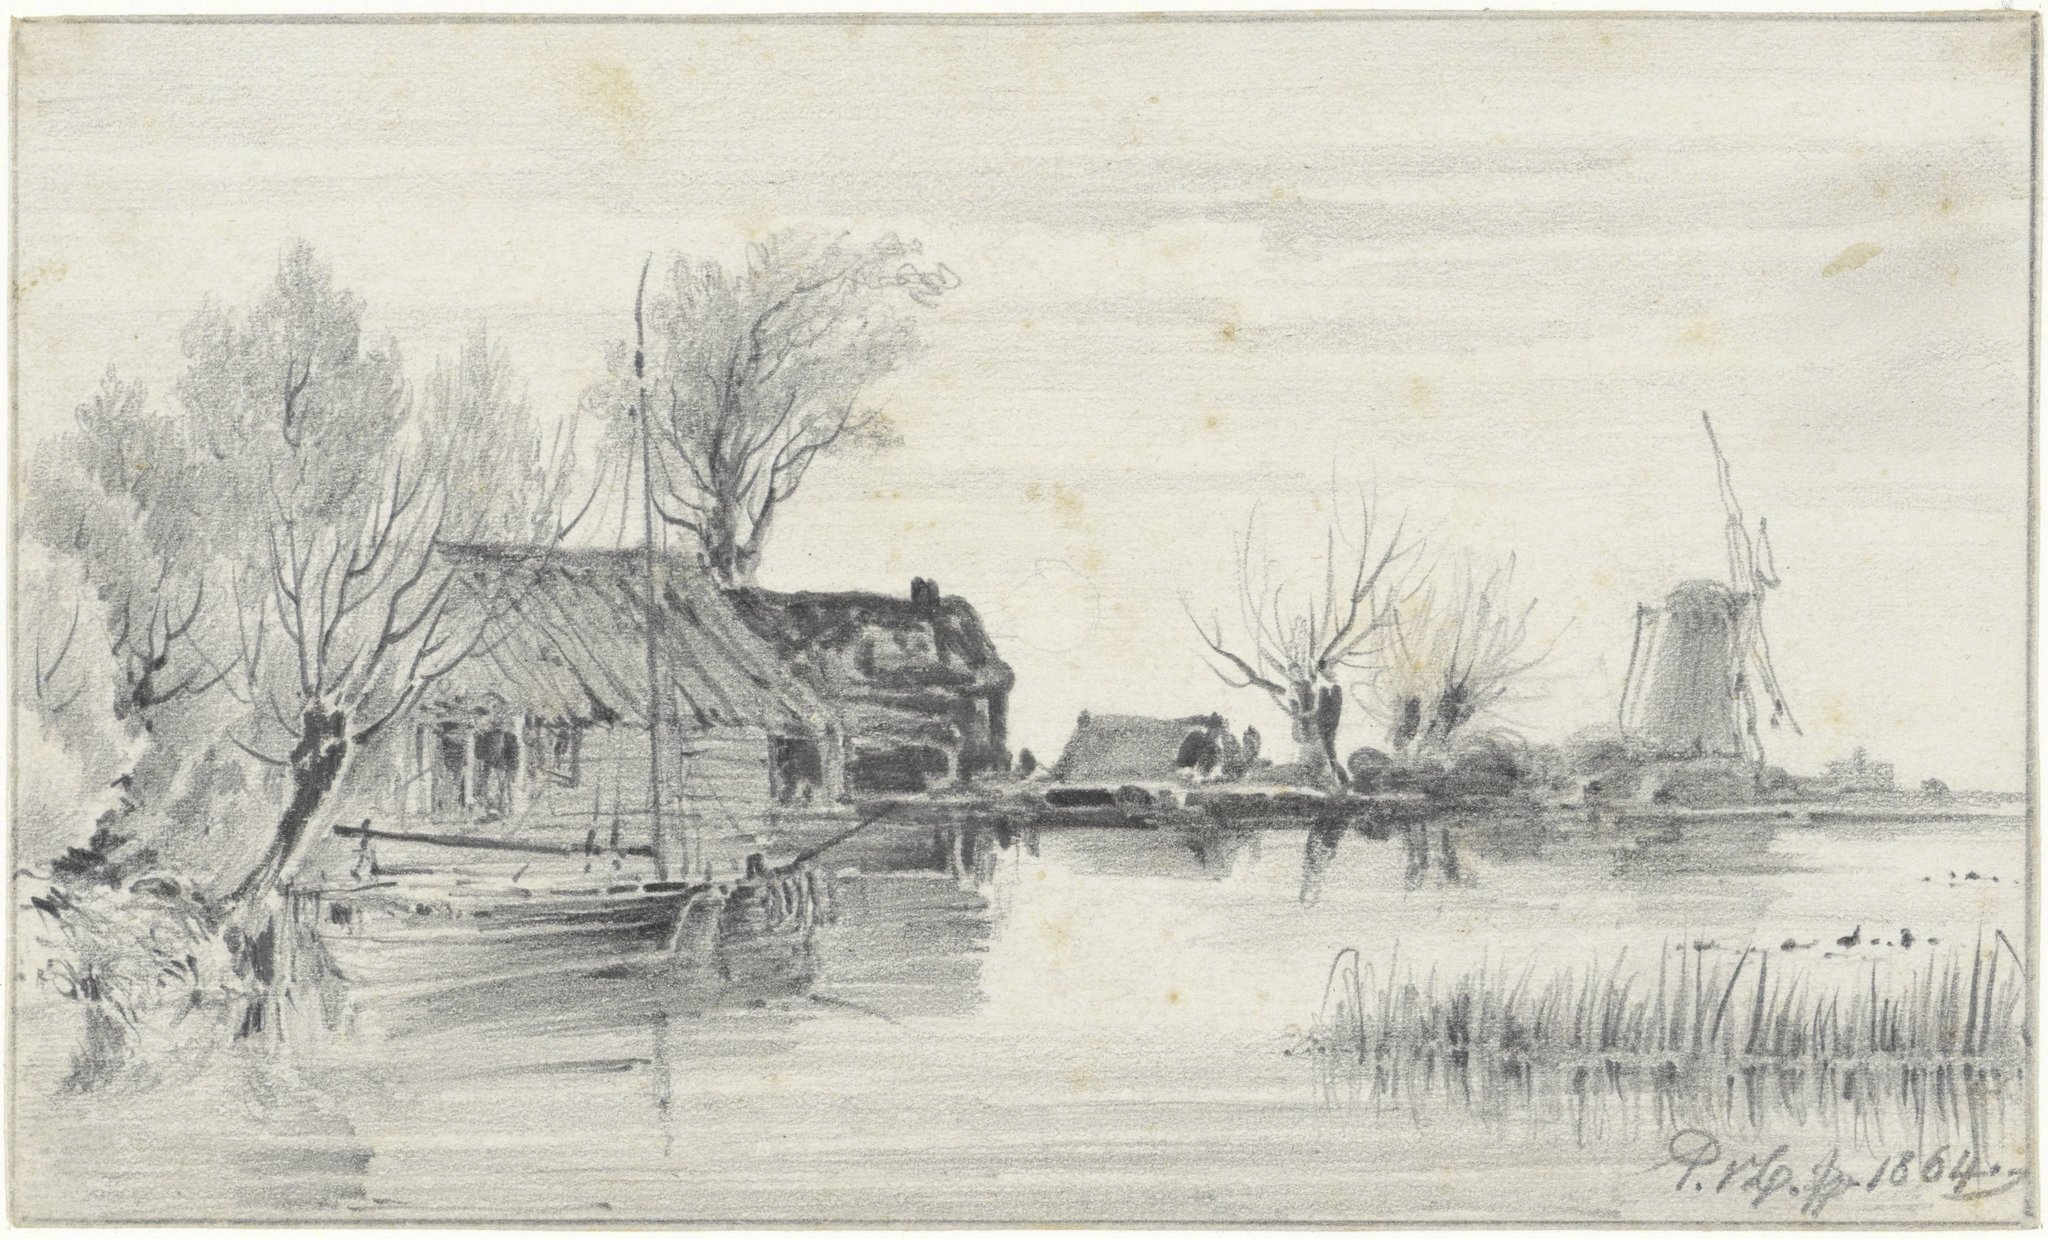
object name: drawing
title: Rivierlandschap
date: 1864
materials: paper, pencil